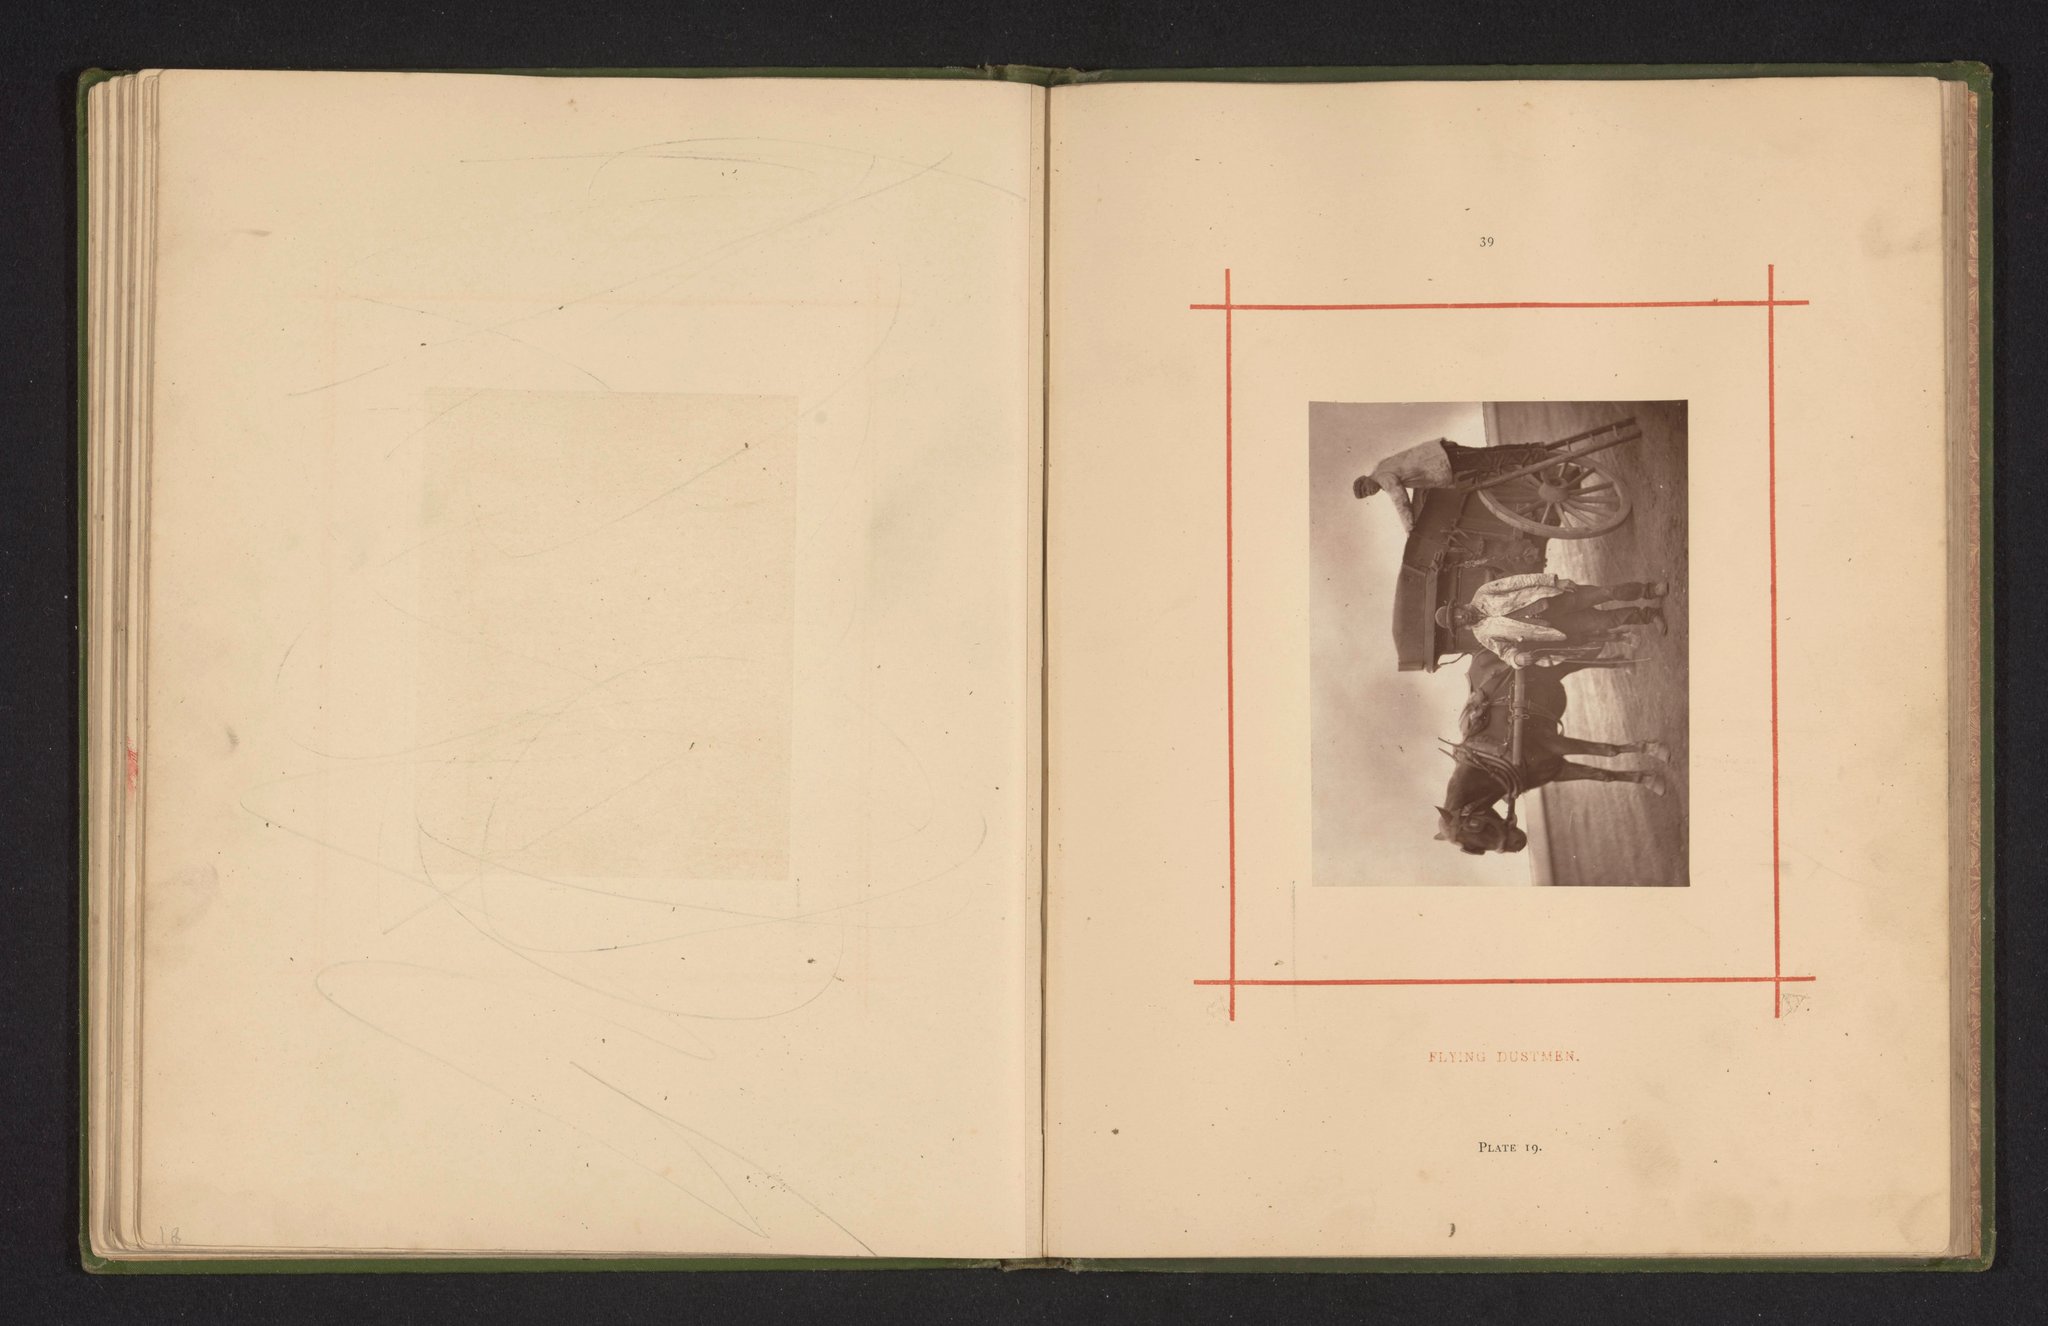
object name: photomechanical print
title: Flying dustmen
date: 1871-1881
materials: paper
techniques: woodburytype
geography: london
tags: street sweeping, street sweeper, (farm) wagon, freight wagon, cart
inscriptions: number: ‘Plate 18.’